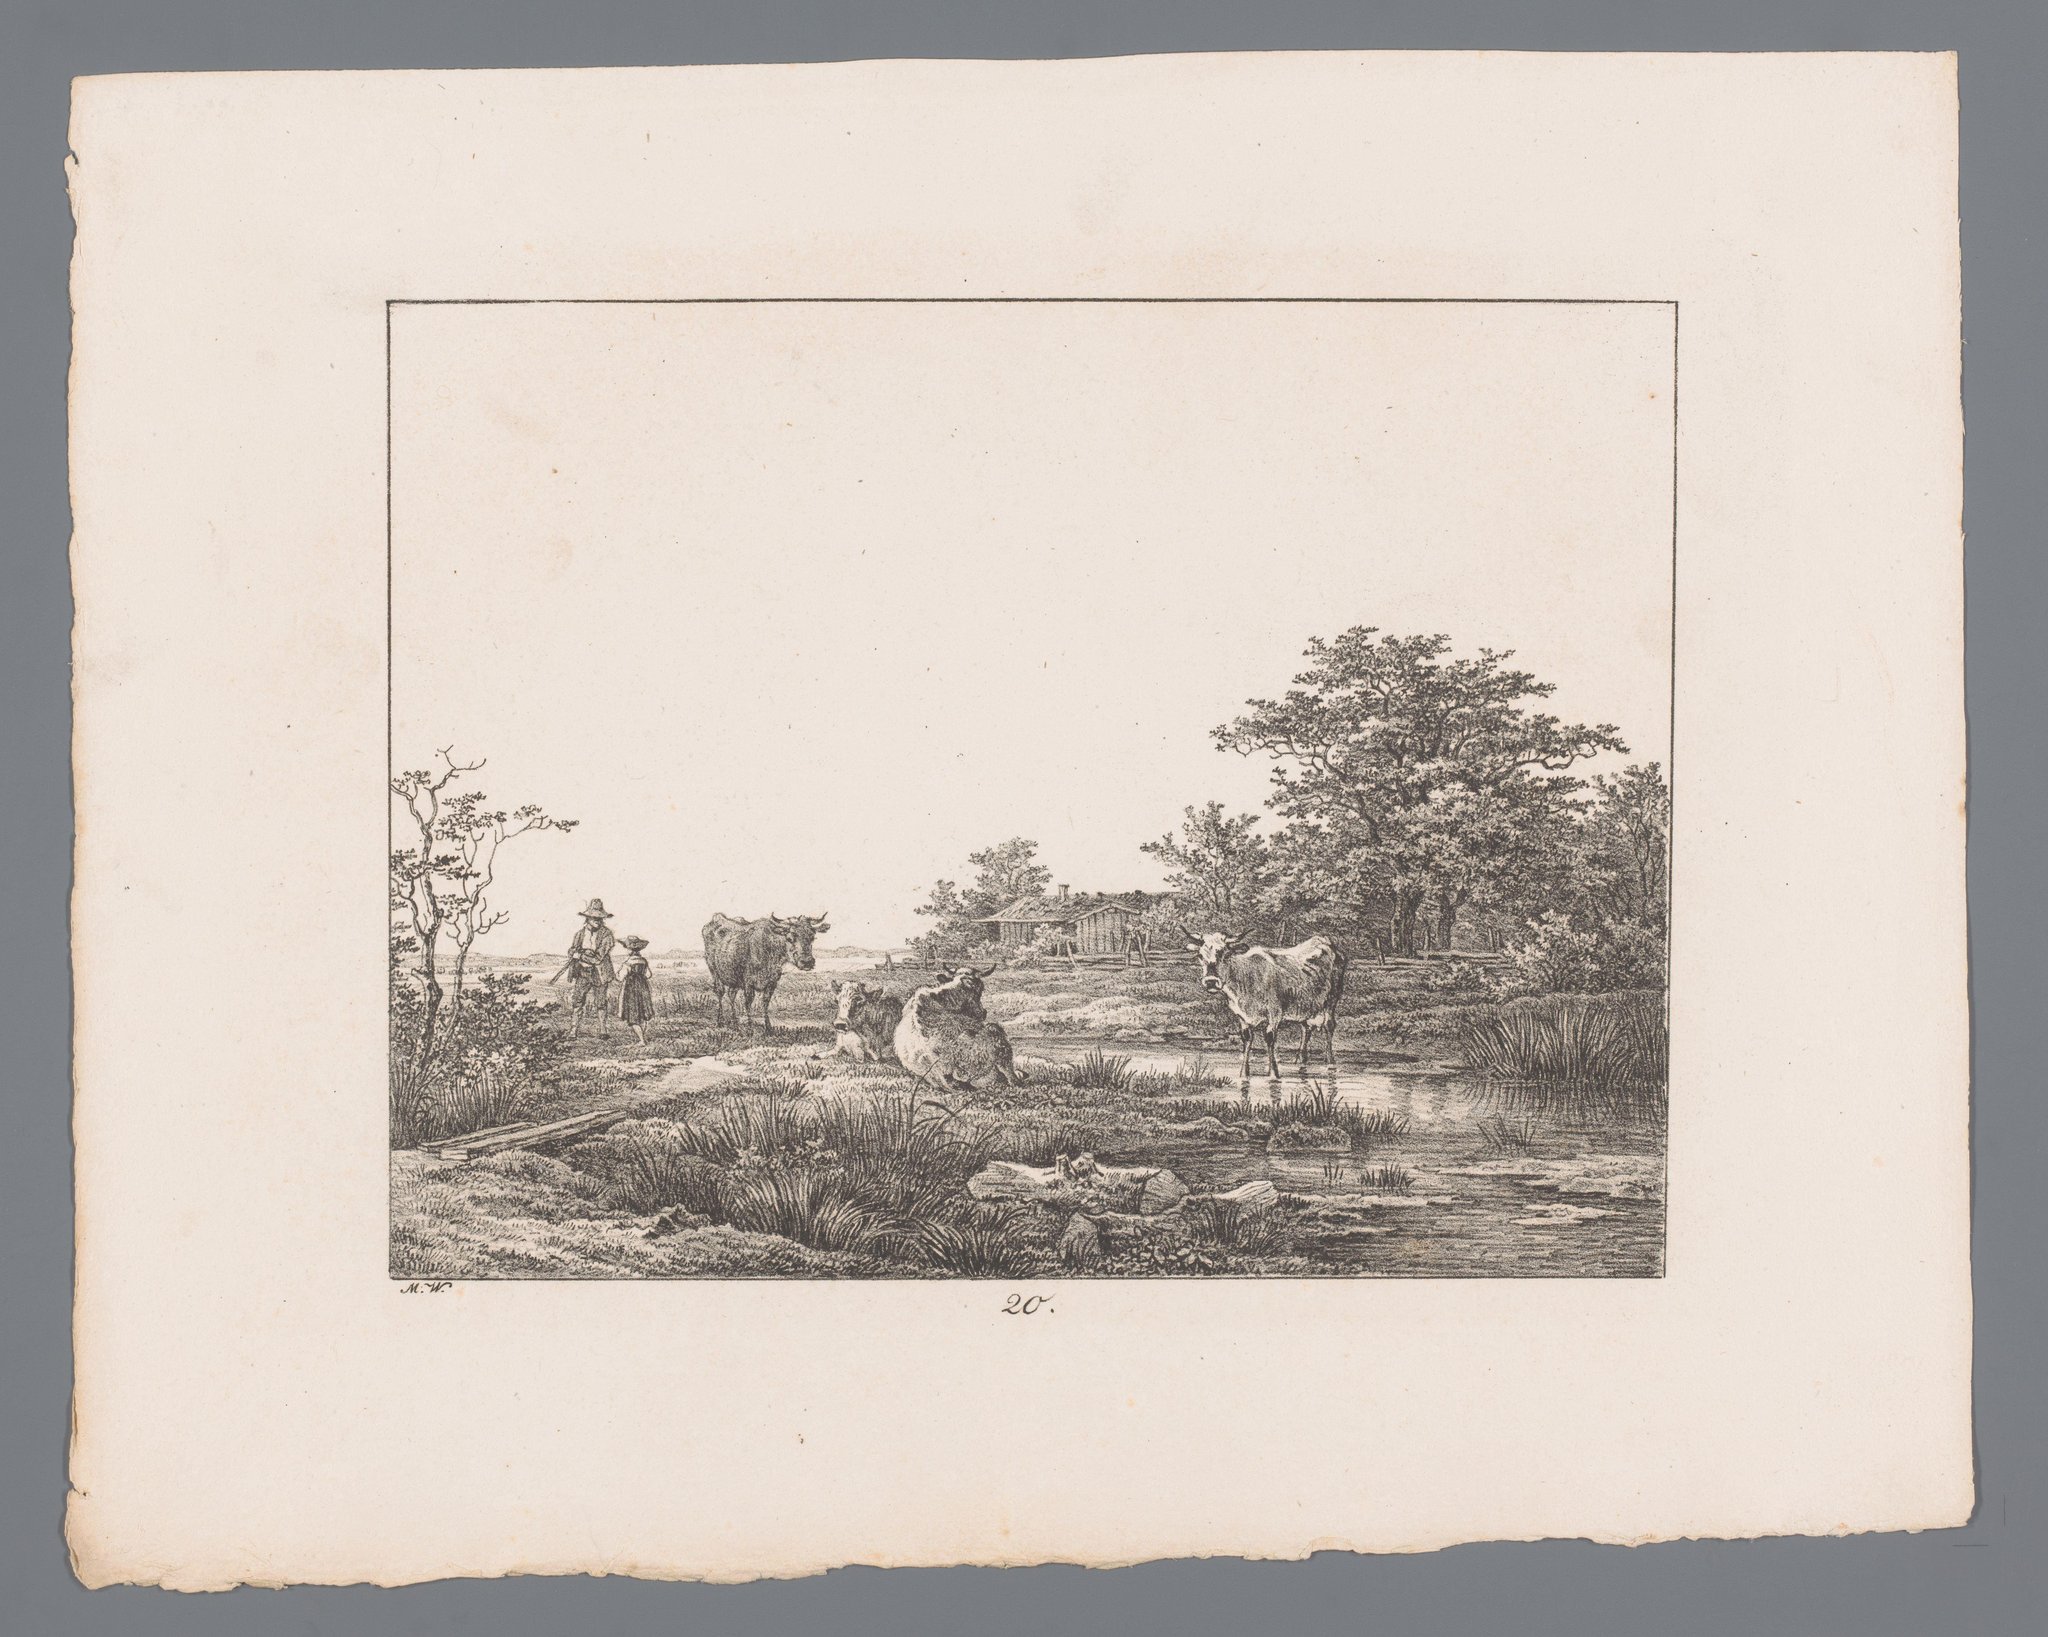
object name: print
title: Koeien bij een oever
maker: max josef wagenbauer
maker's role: print maker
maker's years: 1774-1829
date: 1823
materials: paper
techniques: lithograph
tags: cattle, river bank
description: Onderdeel van een tweedelige serie waarvan het eerste deel bestaat uit een titelprent en twintig voorstellingen van takken, bladeren, bomen en landschappen.